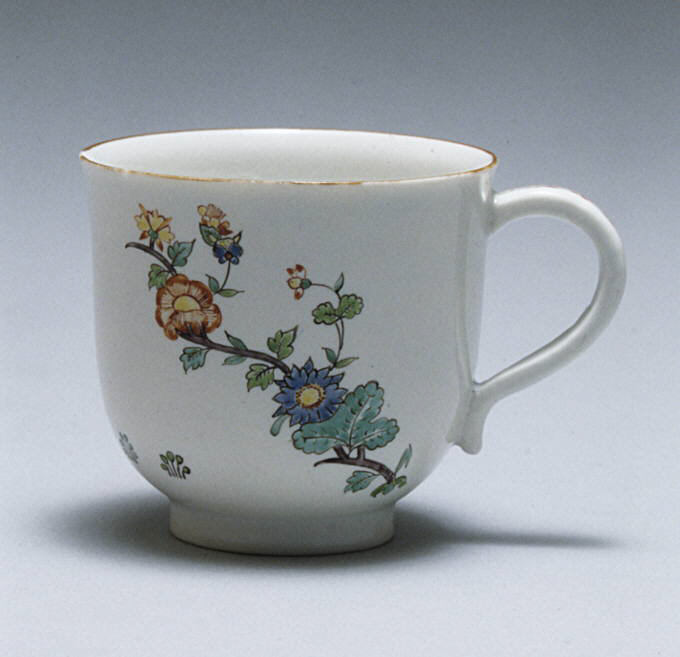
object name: cup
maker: chantilly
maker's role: factory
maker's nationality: french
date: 1735-1740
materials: soft paste porcelain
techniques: glazing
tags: flowers